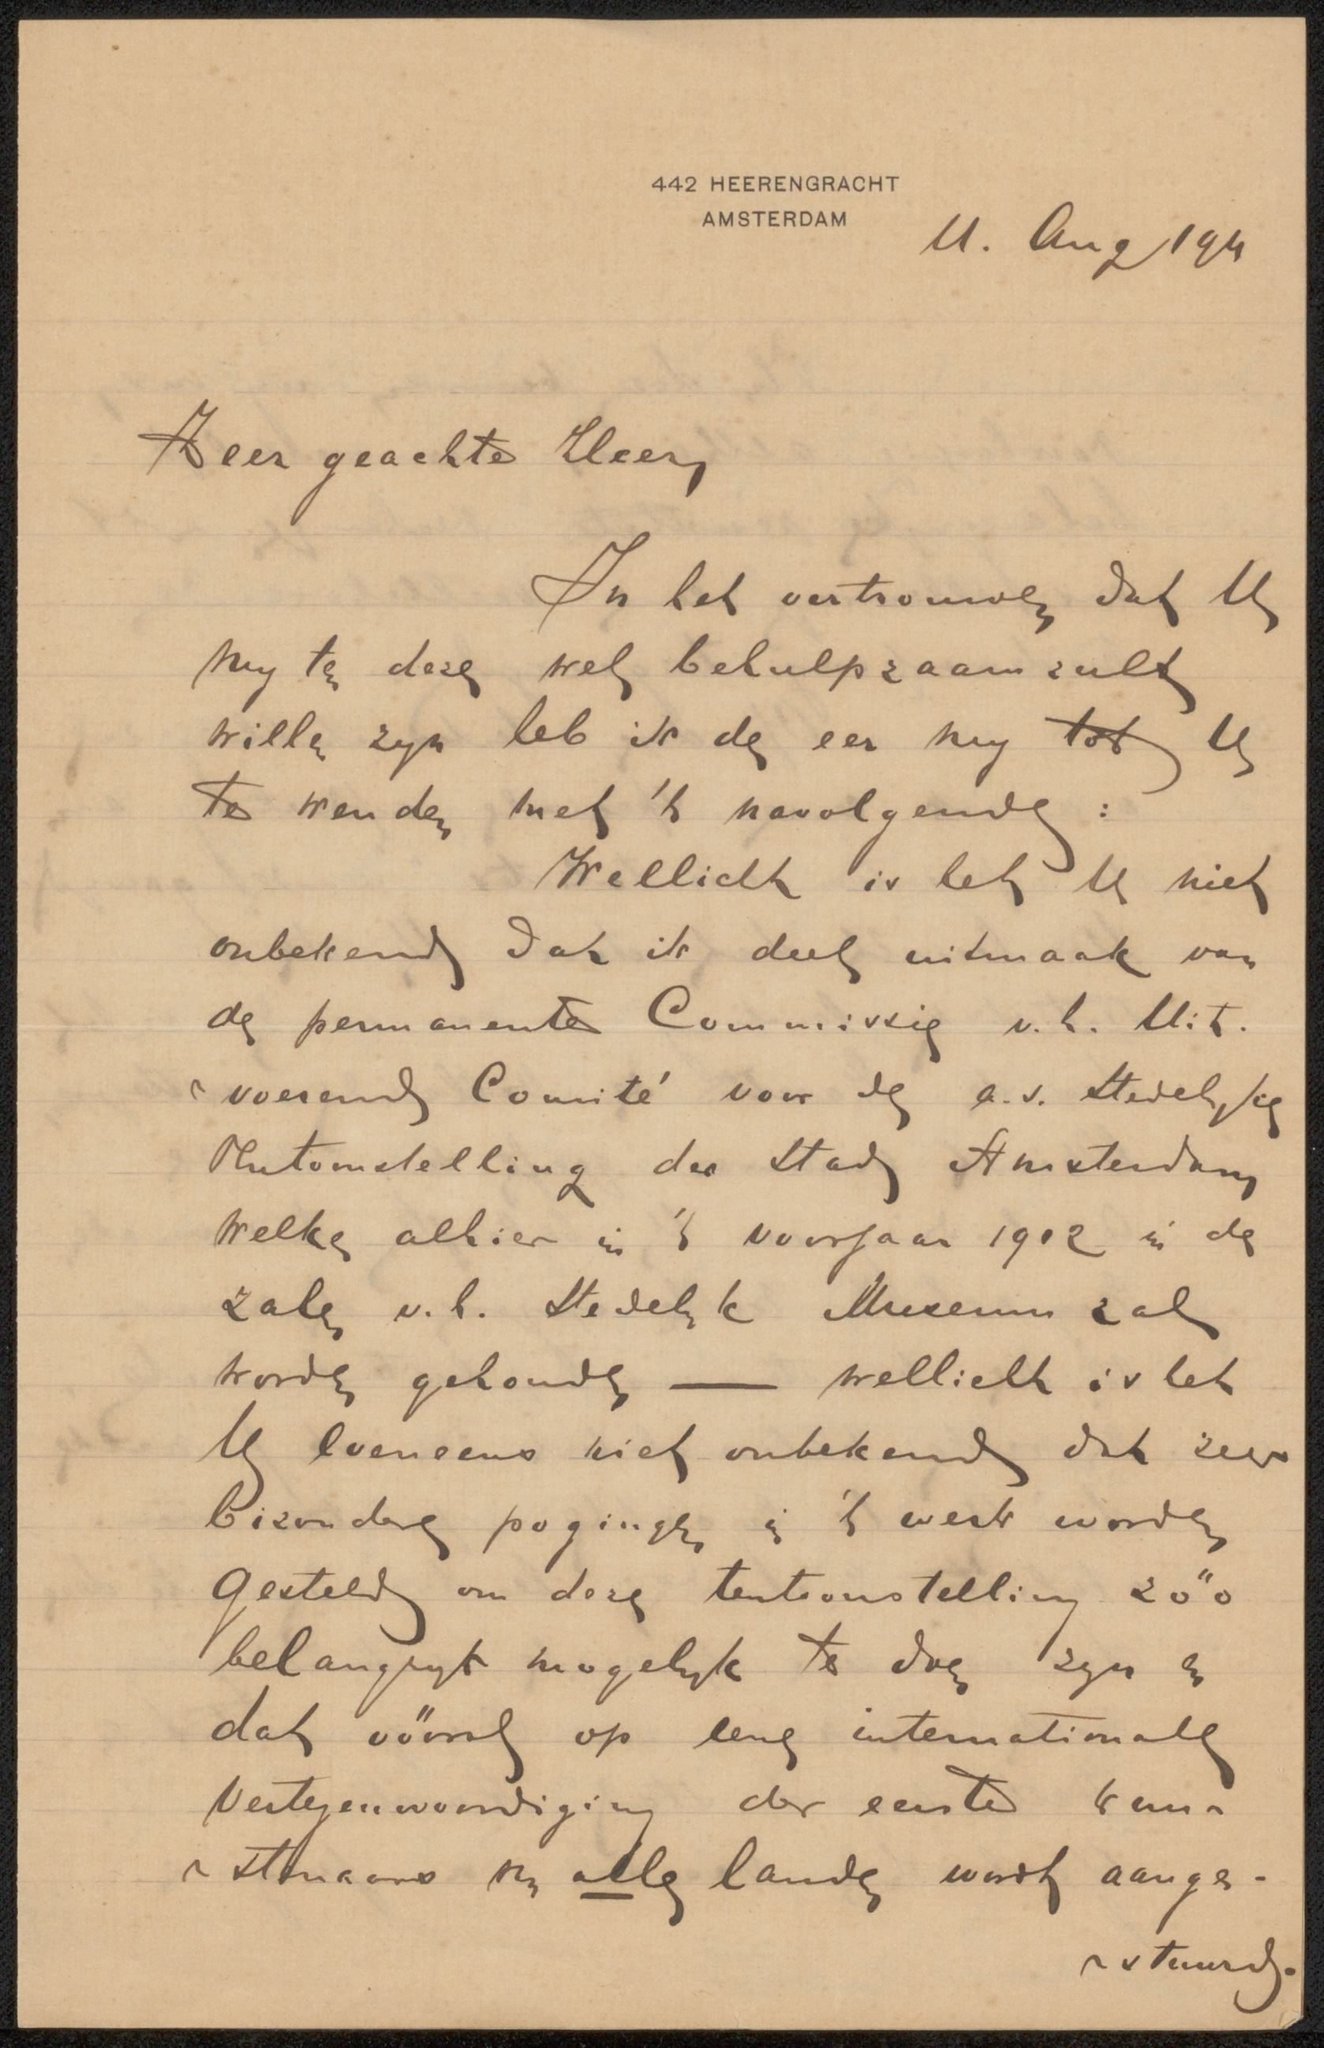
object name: letter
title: Brief aan Philip Zilcken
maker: gerard muller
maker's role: draughtsman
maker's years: 1861-1929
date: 1911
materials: ink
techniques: pen, printing, writing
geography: amsterdam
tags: the hague, draughtsman, philip zilcken, exhibition ~ art, amsterdam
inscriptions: collector's mark: ‘RPK’